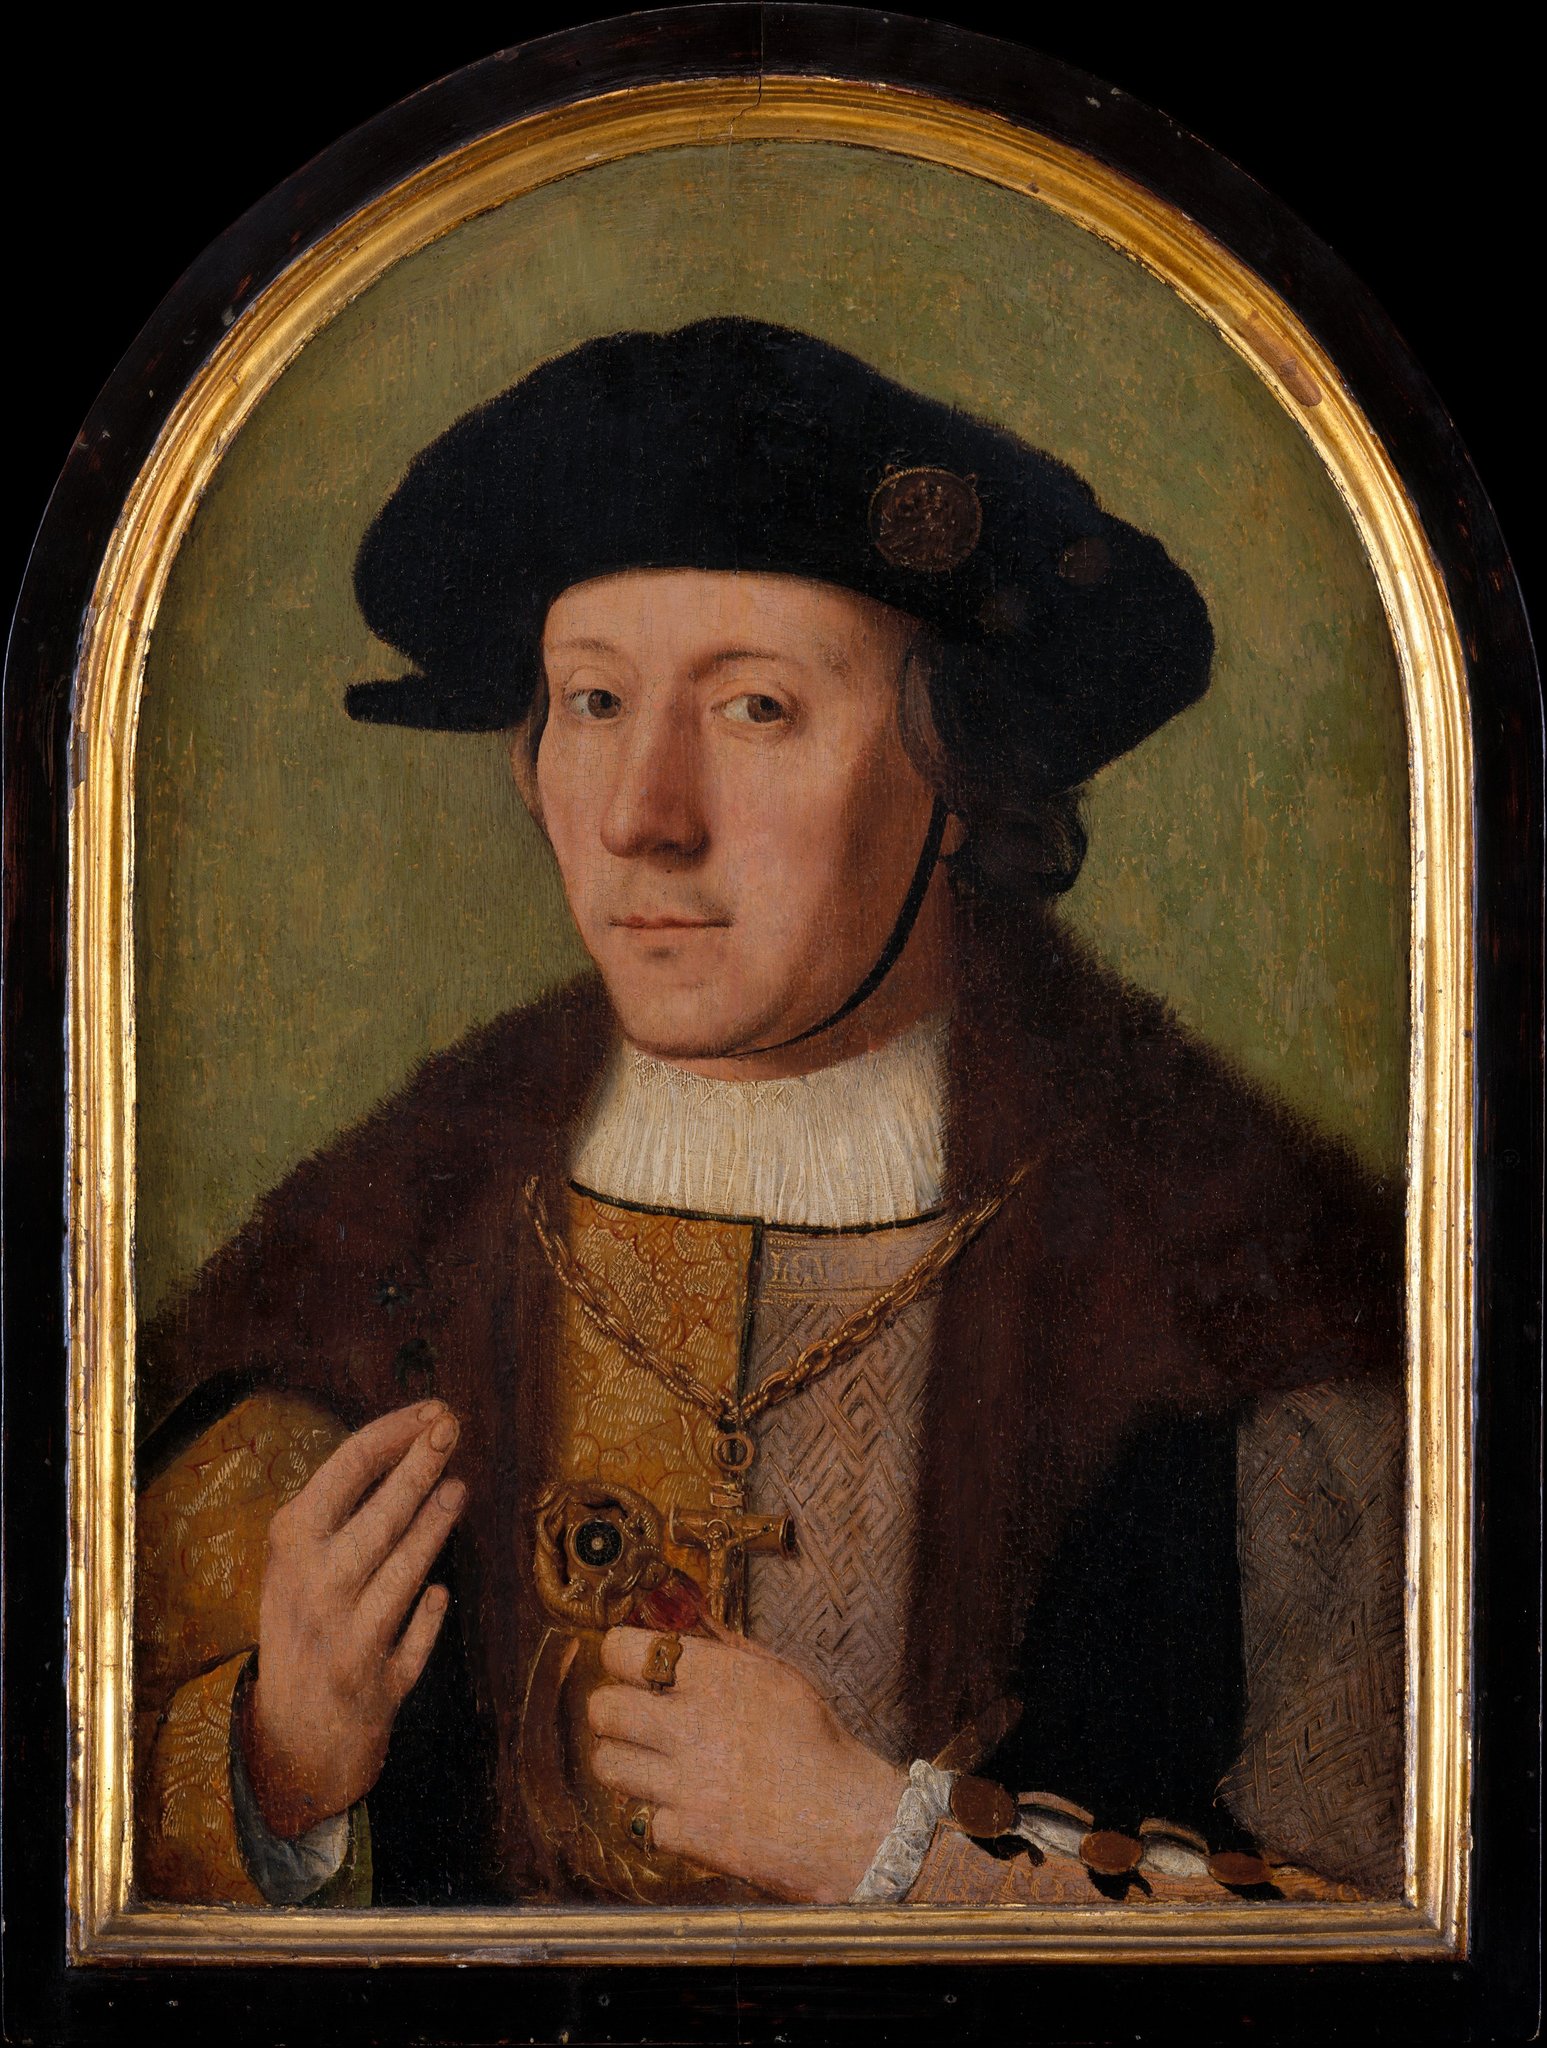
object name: painting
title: Portrait of a Man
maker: quinten massys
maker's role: artist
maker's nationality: netherlandish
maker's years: 1466-1530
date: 1485-1530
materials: oil, wood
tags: men,portraits